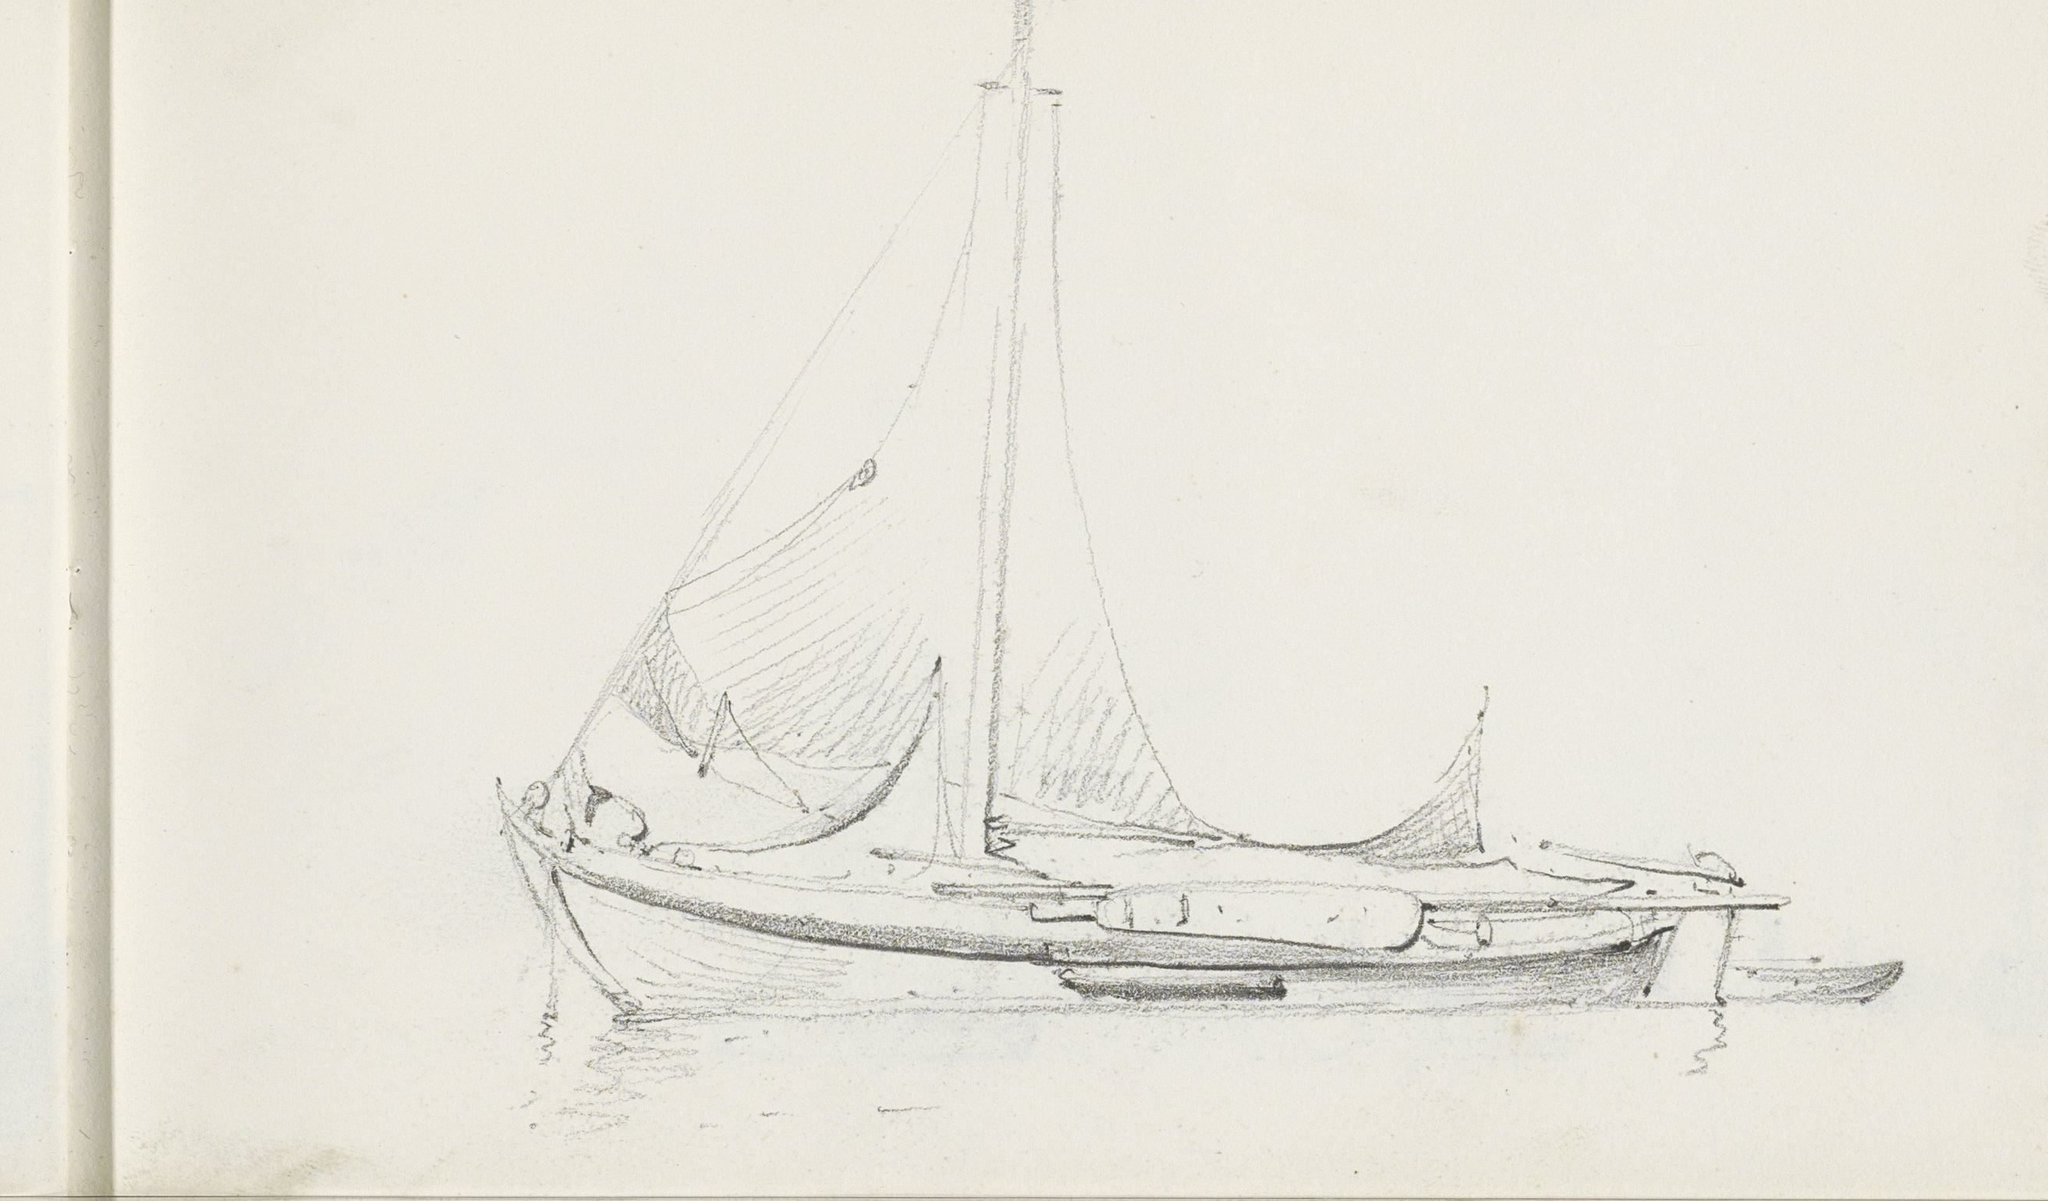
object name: sketchbook leaf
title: Zeilboot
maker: petrus johannes schotel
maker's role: draughtsman, painter, print maker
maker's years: 1808-1865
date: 1841-1865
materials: paper, pencil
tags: sailing-ship, sailing-boat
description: Pagina 61 uit een schetsboek met 80 pagina's.